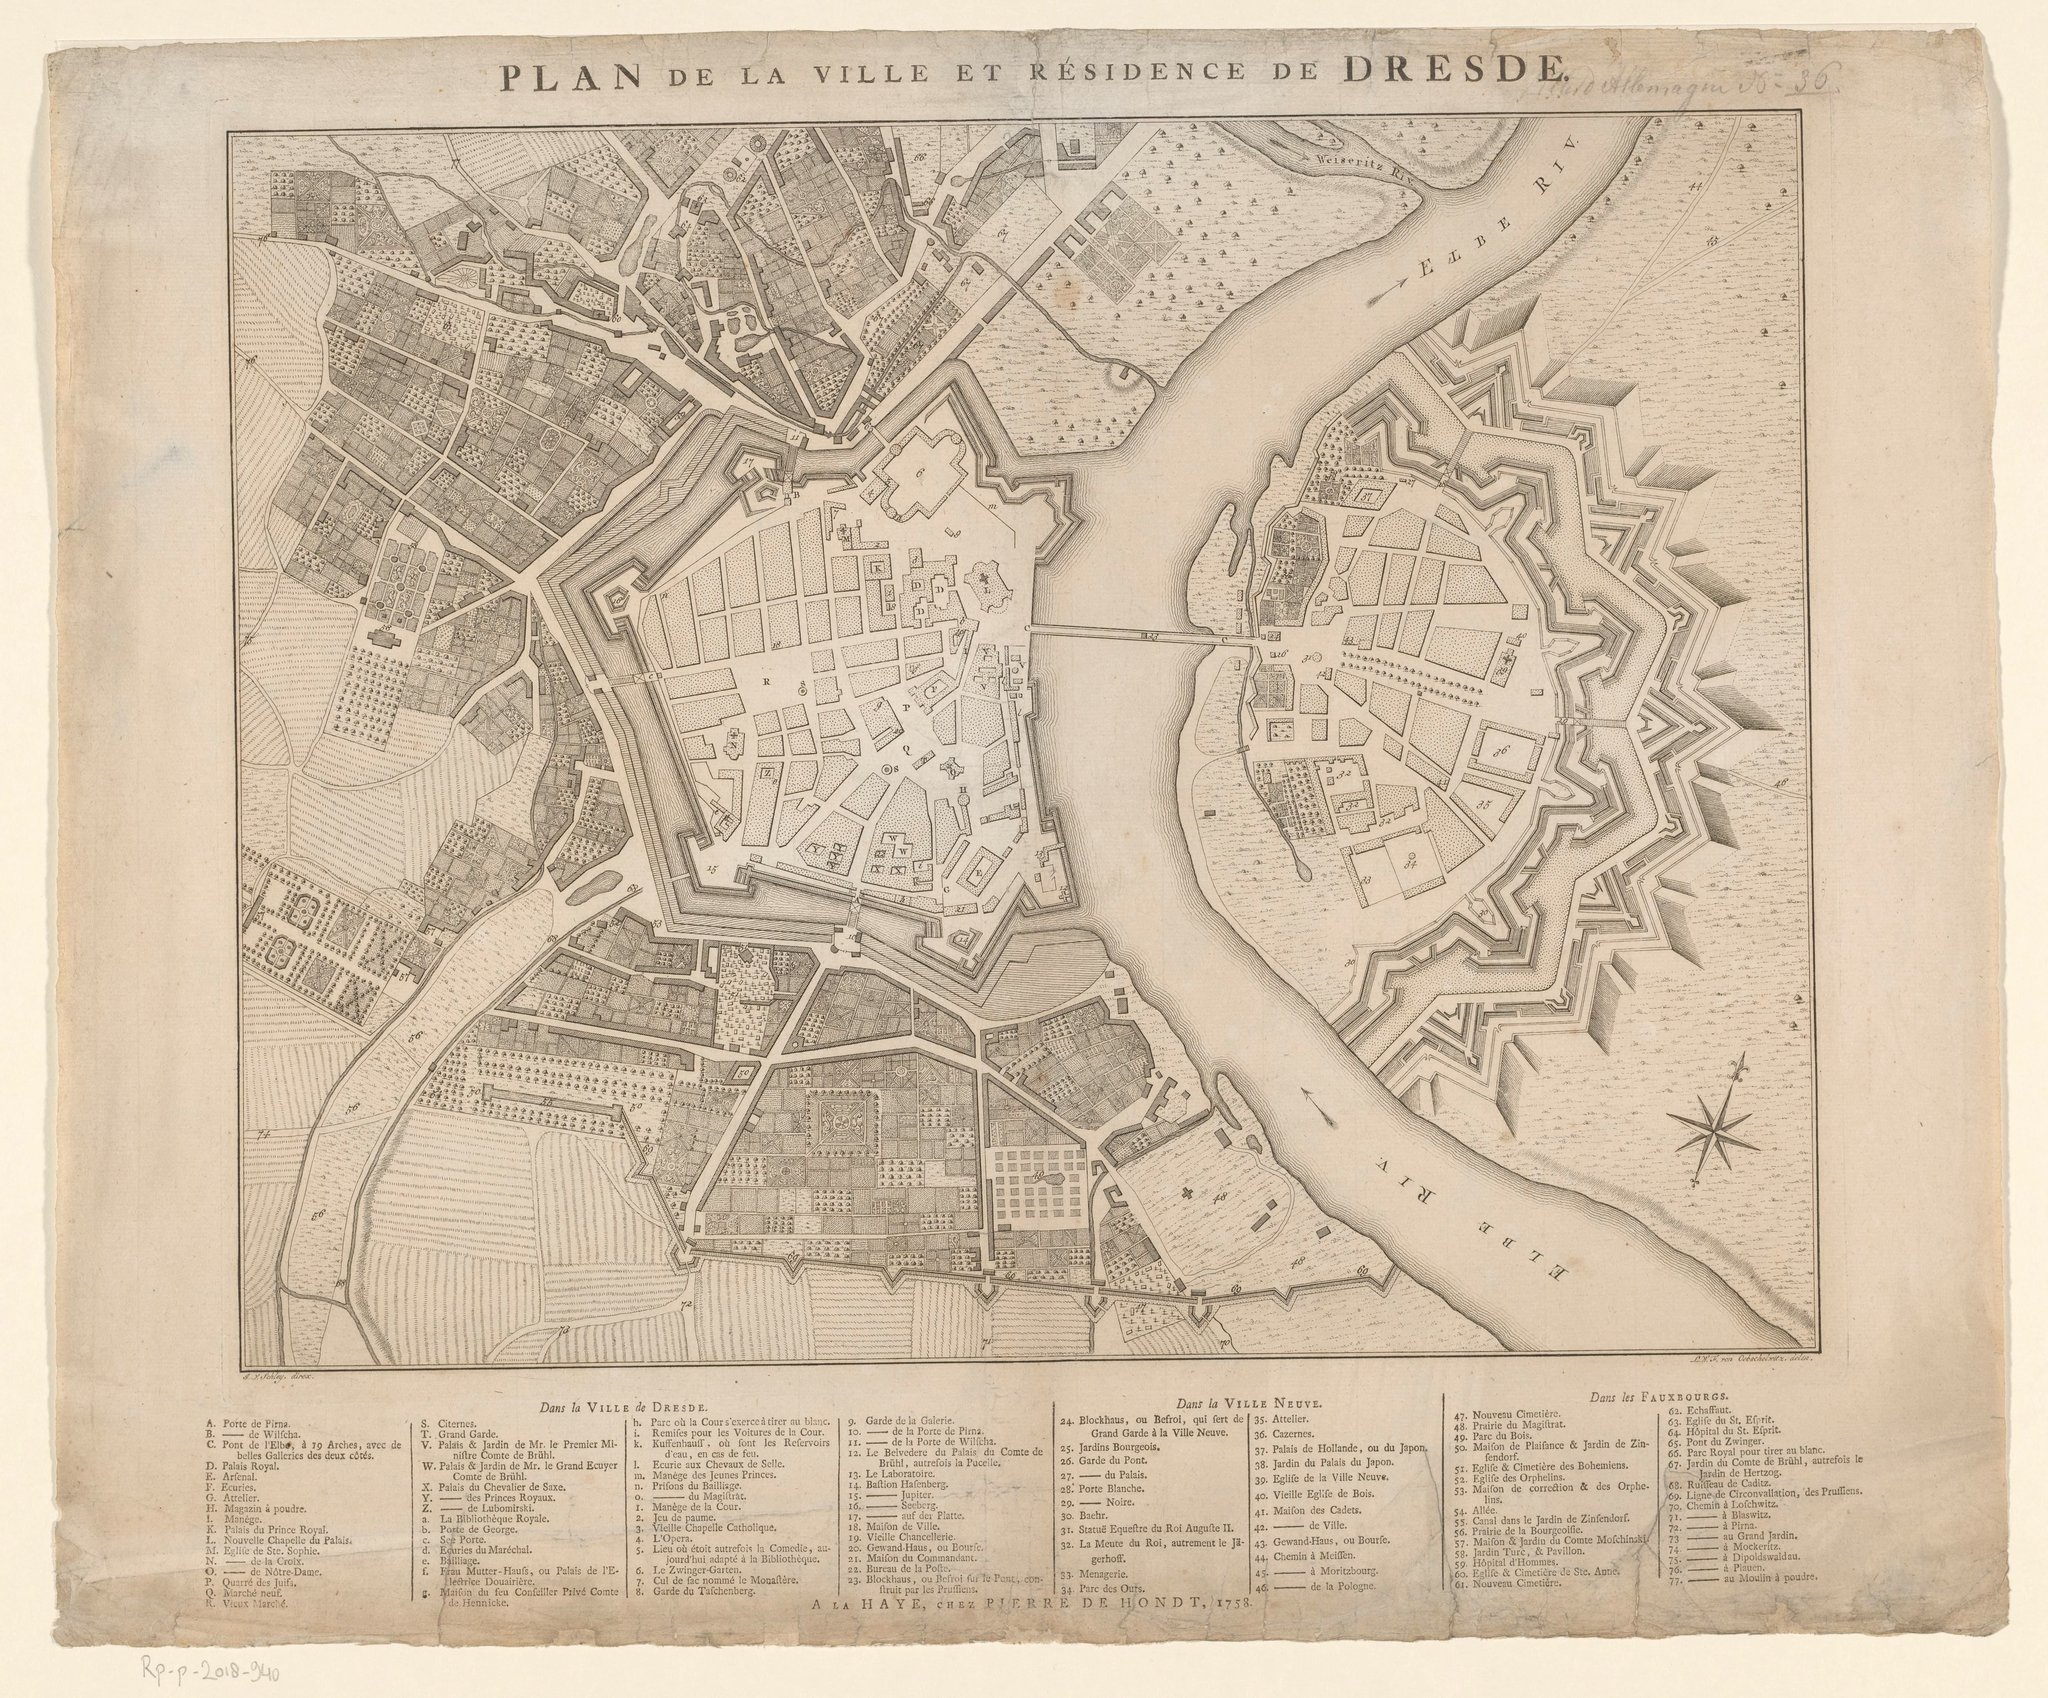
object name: print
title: Plattegrond van Dresden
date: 1758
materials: paper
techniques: etching, letterpress printing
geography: the hague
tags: maps of cities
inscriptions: collector's mark: Lugt 2228